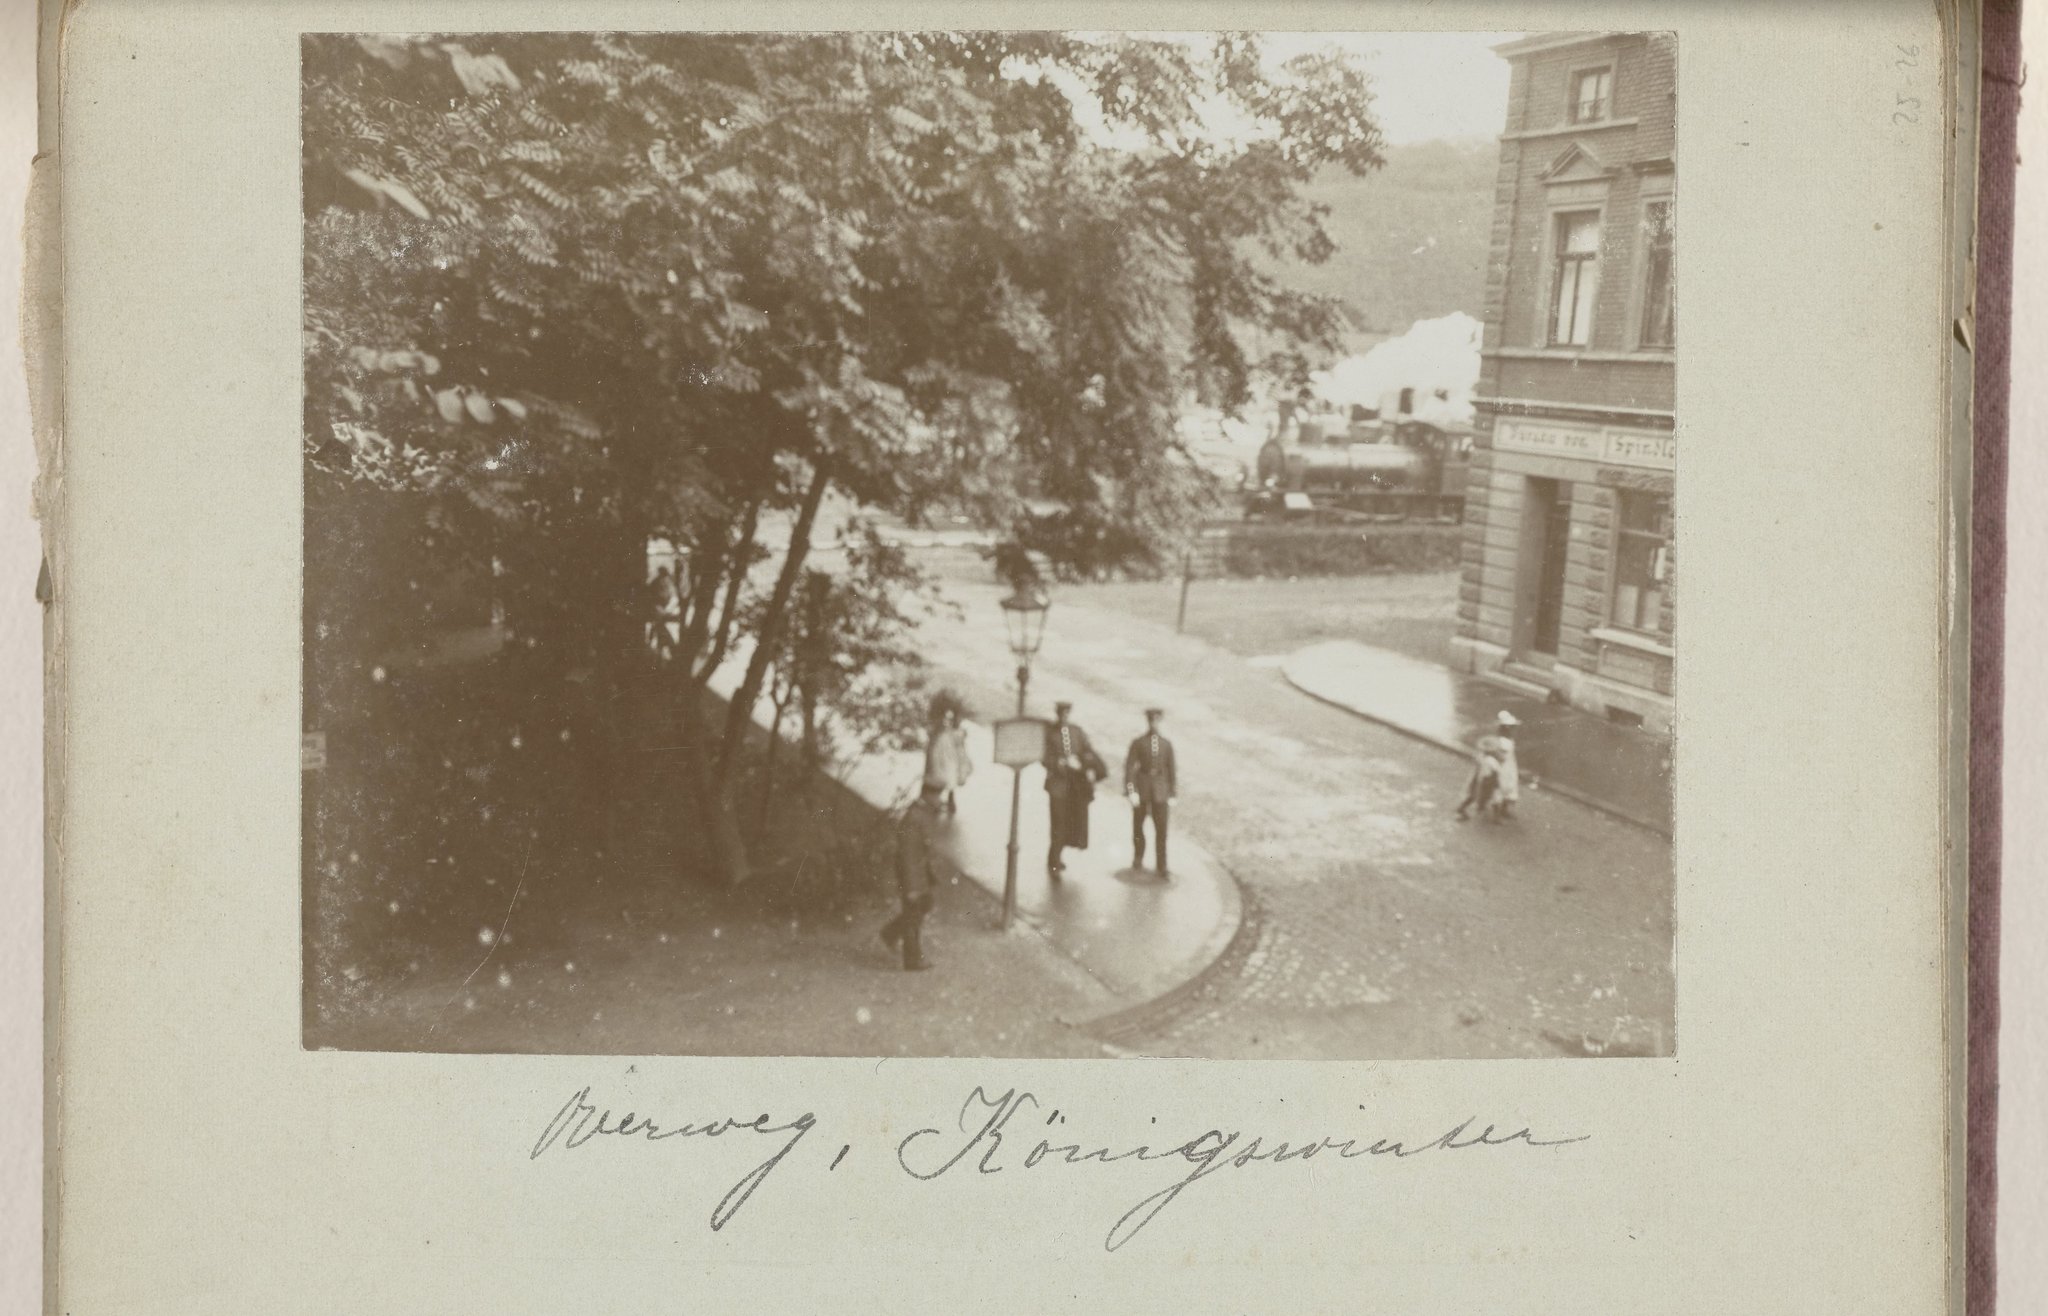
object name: album leaf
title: Overweg, Königswinter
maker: david vermeulen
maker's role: fotograaf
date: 1895-1905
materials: paper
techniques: collodion silver print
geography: königswinter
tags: railway, train, street